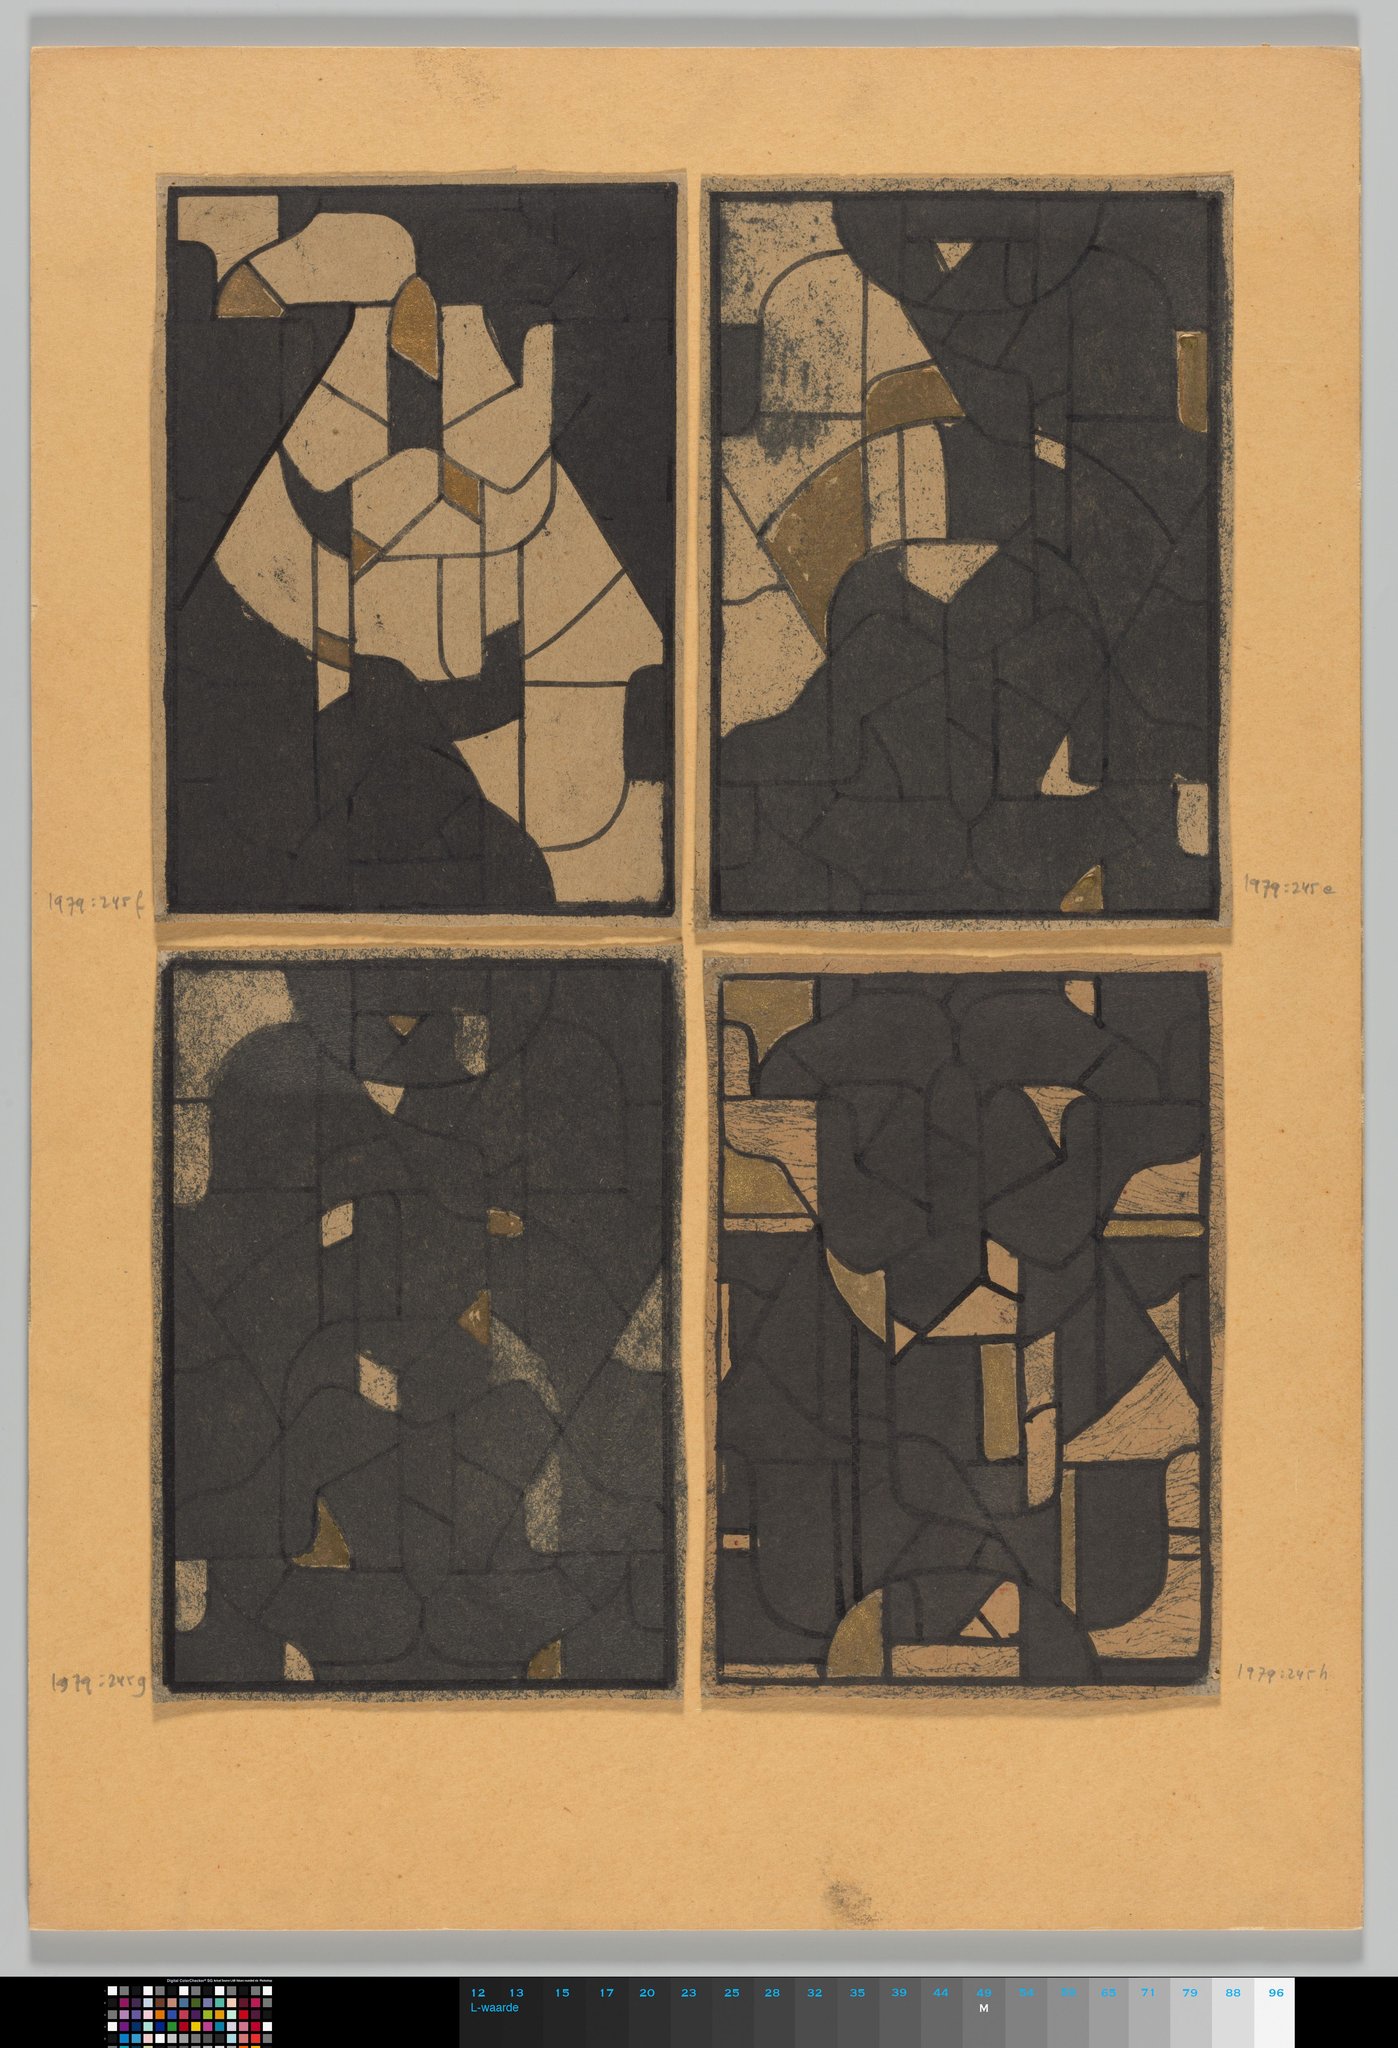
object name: drawing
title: Tapijtontwerp voor raam in het Noordertransept van de Dom te Utrecht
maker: richard nicolaüs roland holst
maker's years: 1868-1938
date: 1868-1938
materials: cardboard, paper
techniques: brush